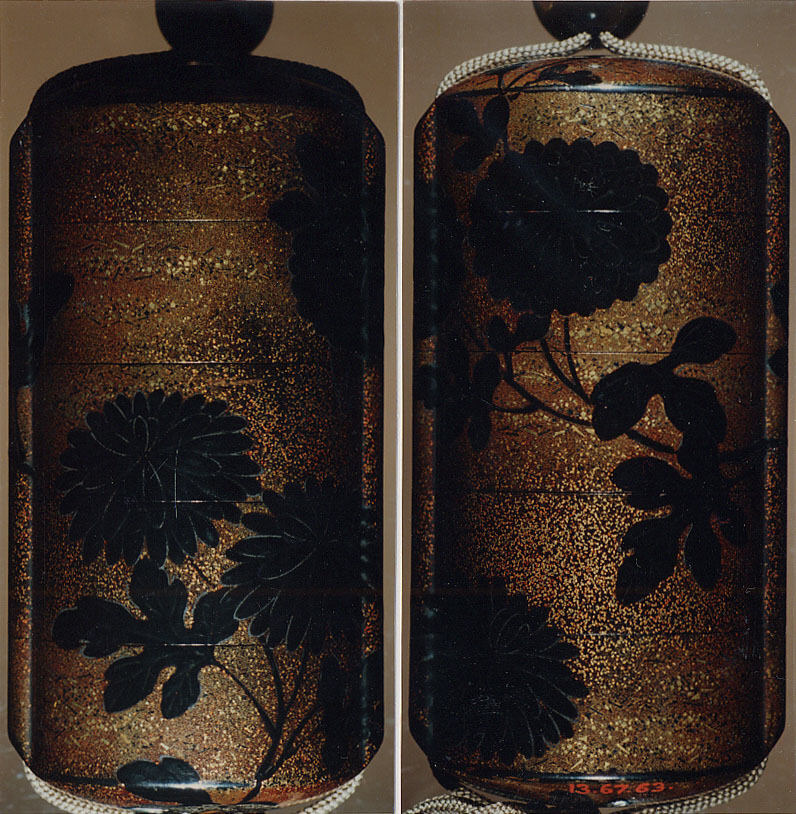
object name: inrō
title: Case (Inrō) with Design of Chrysanthemums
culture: japanese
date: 1801-1900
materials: gold, ivory, lacquer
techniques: carving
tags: flowers